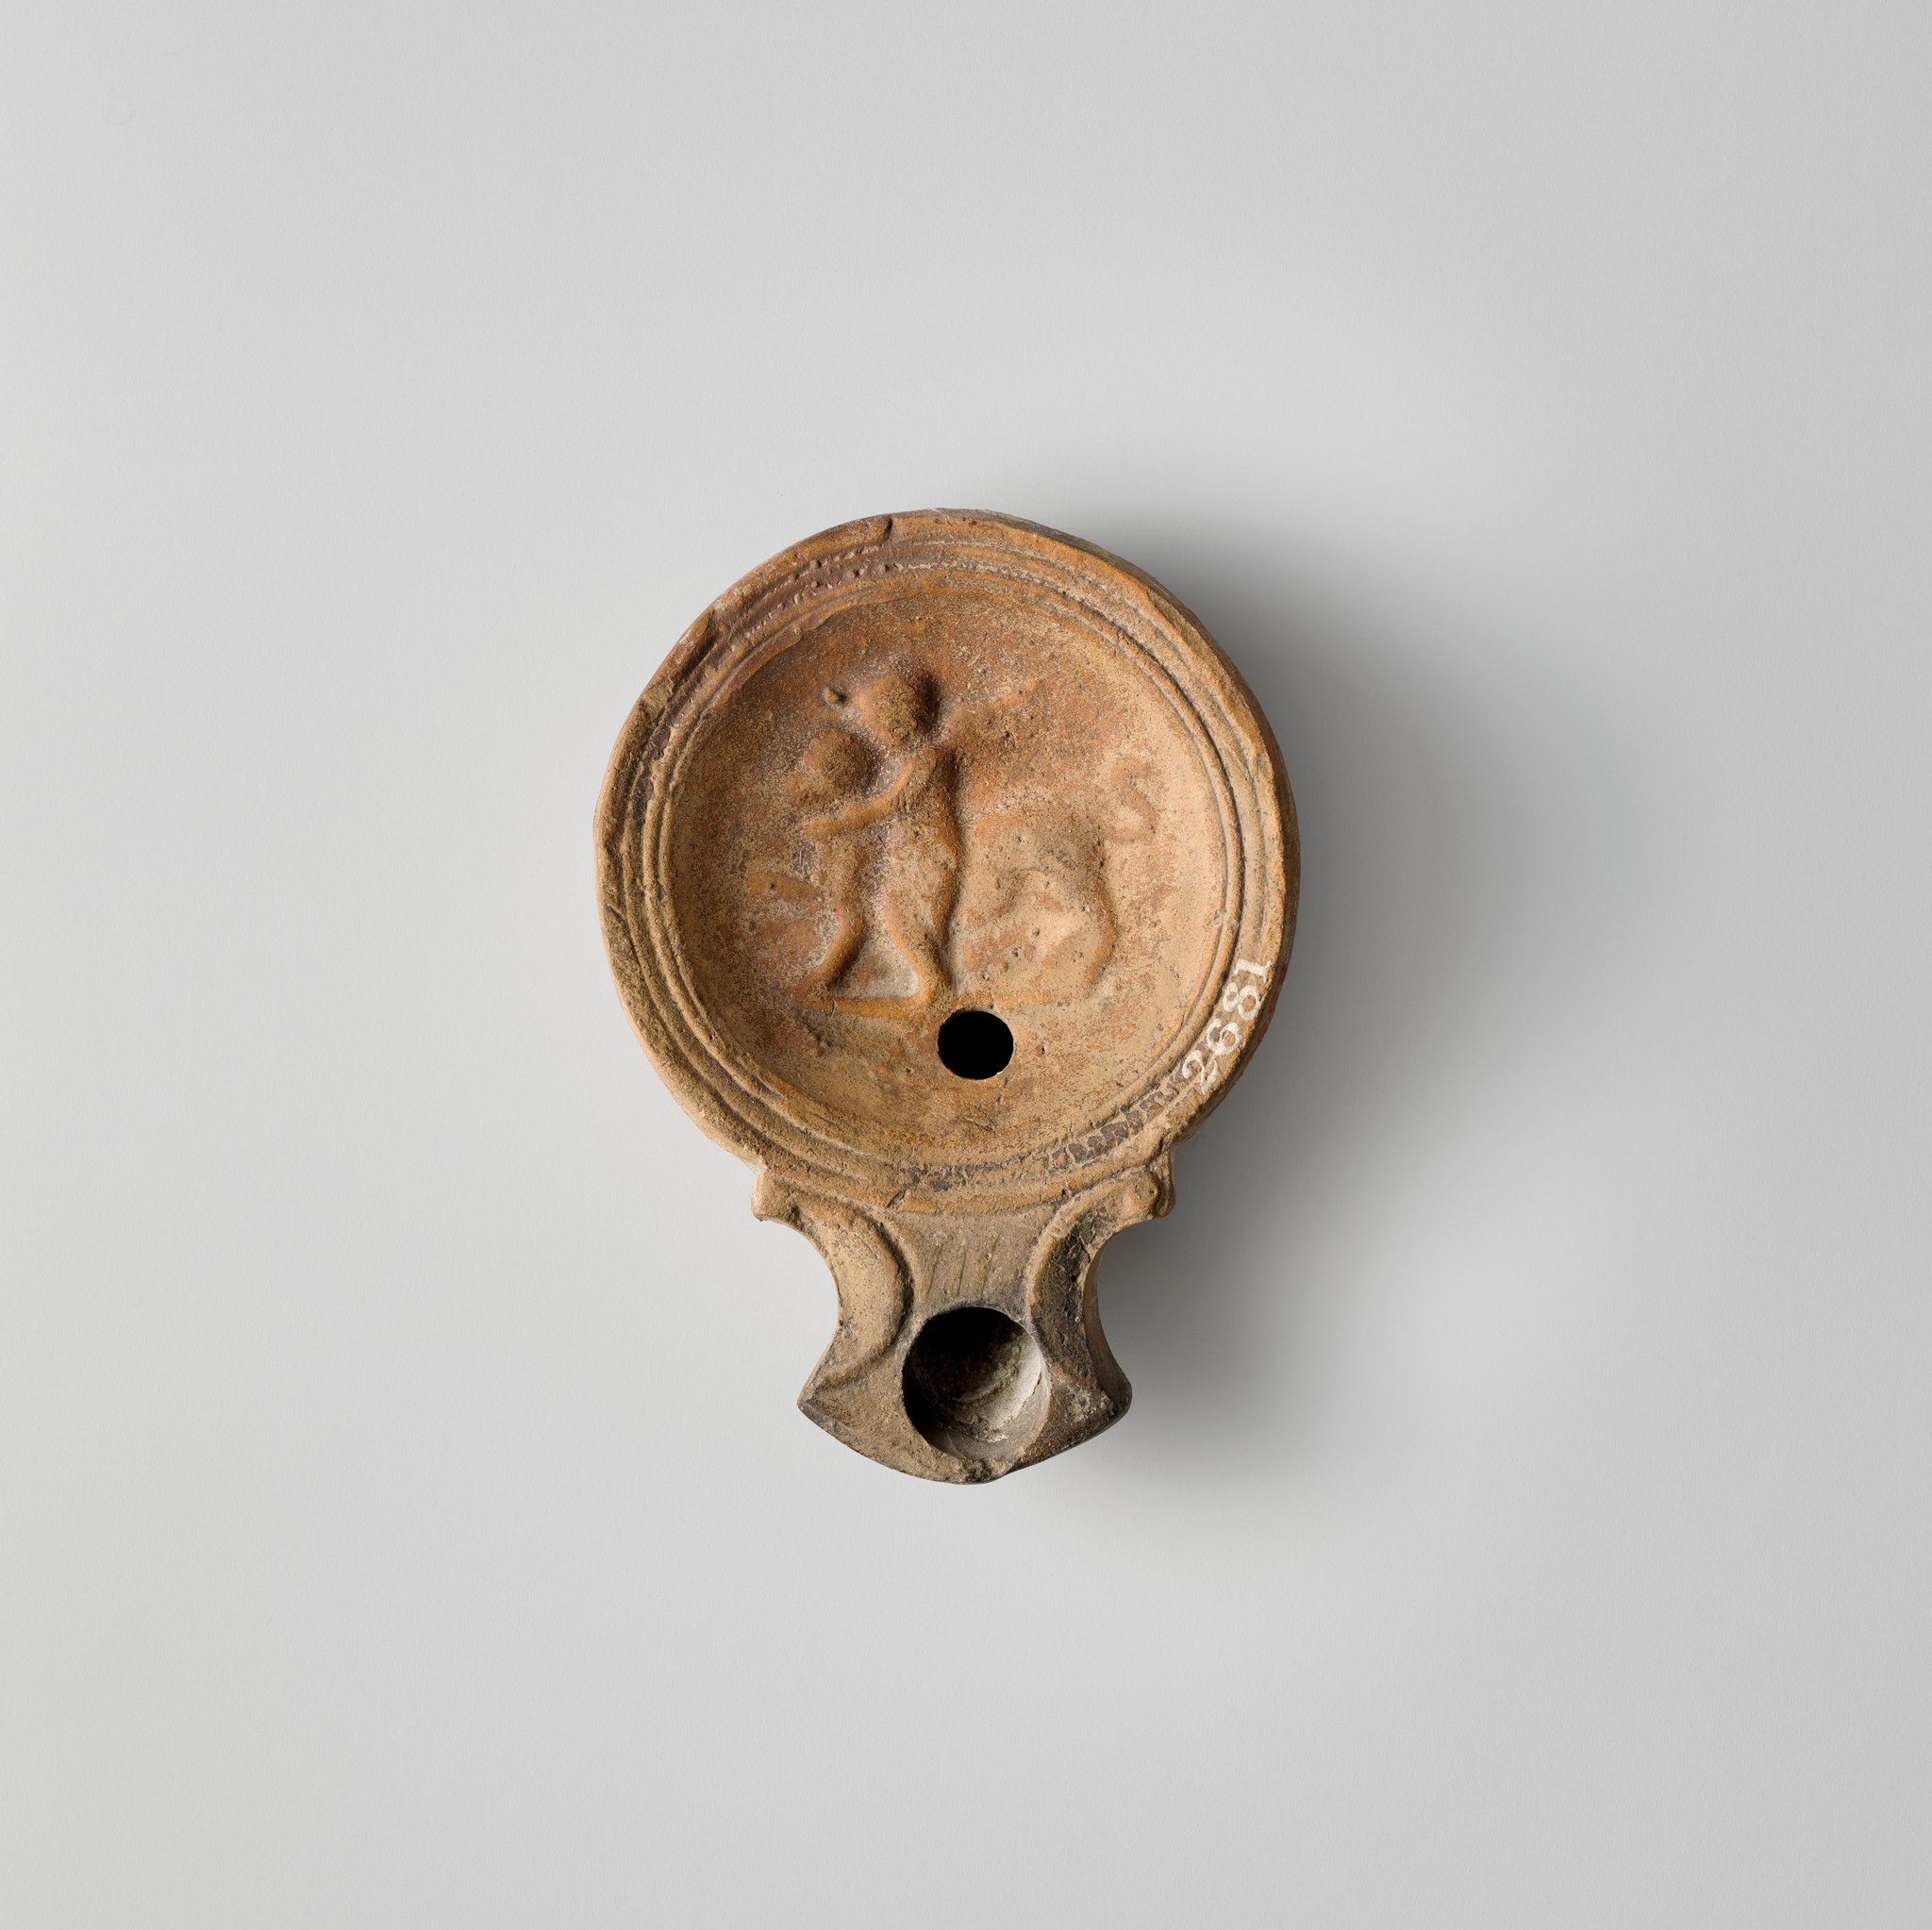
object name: lamp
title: Terracotta oil lamp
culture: roman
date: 1-50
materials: terracotta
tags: eros,lions